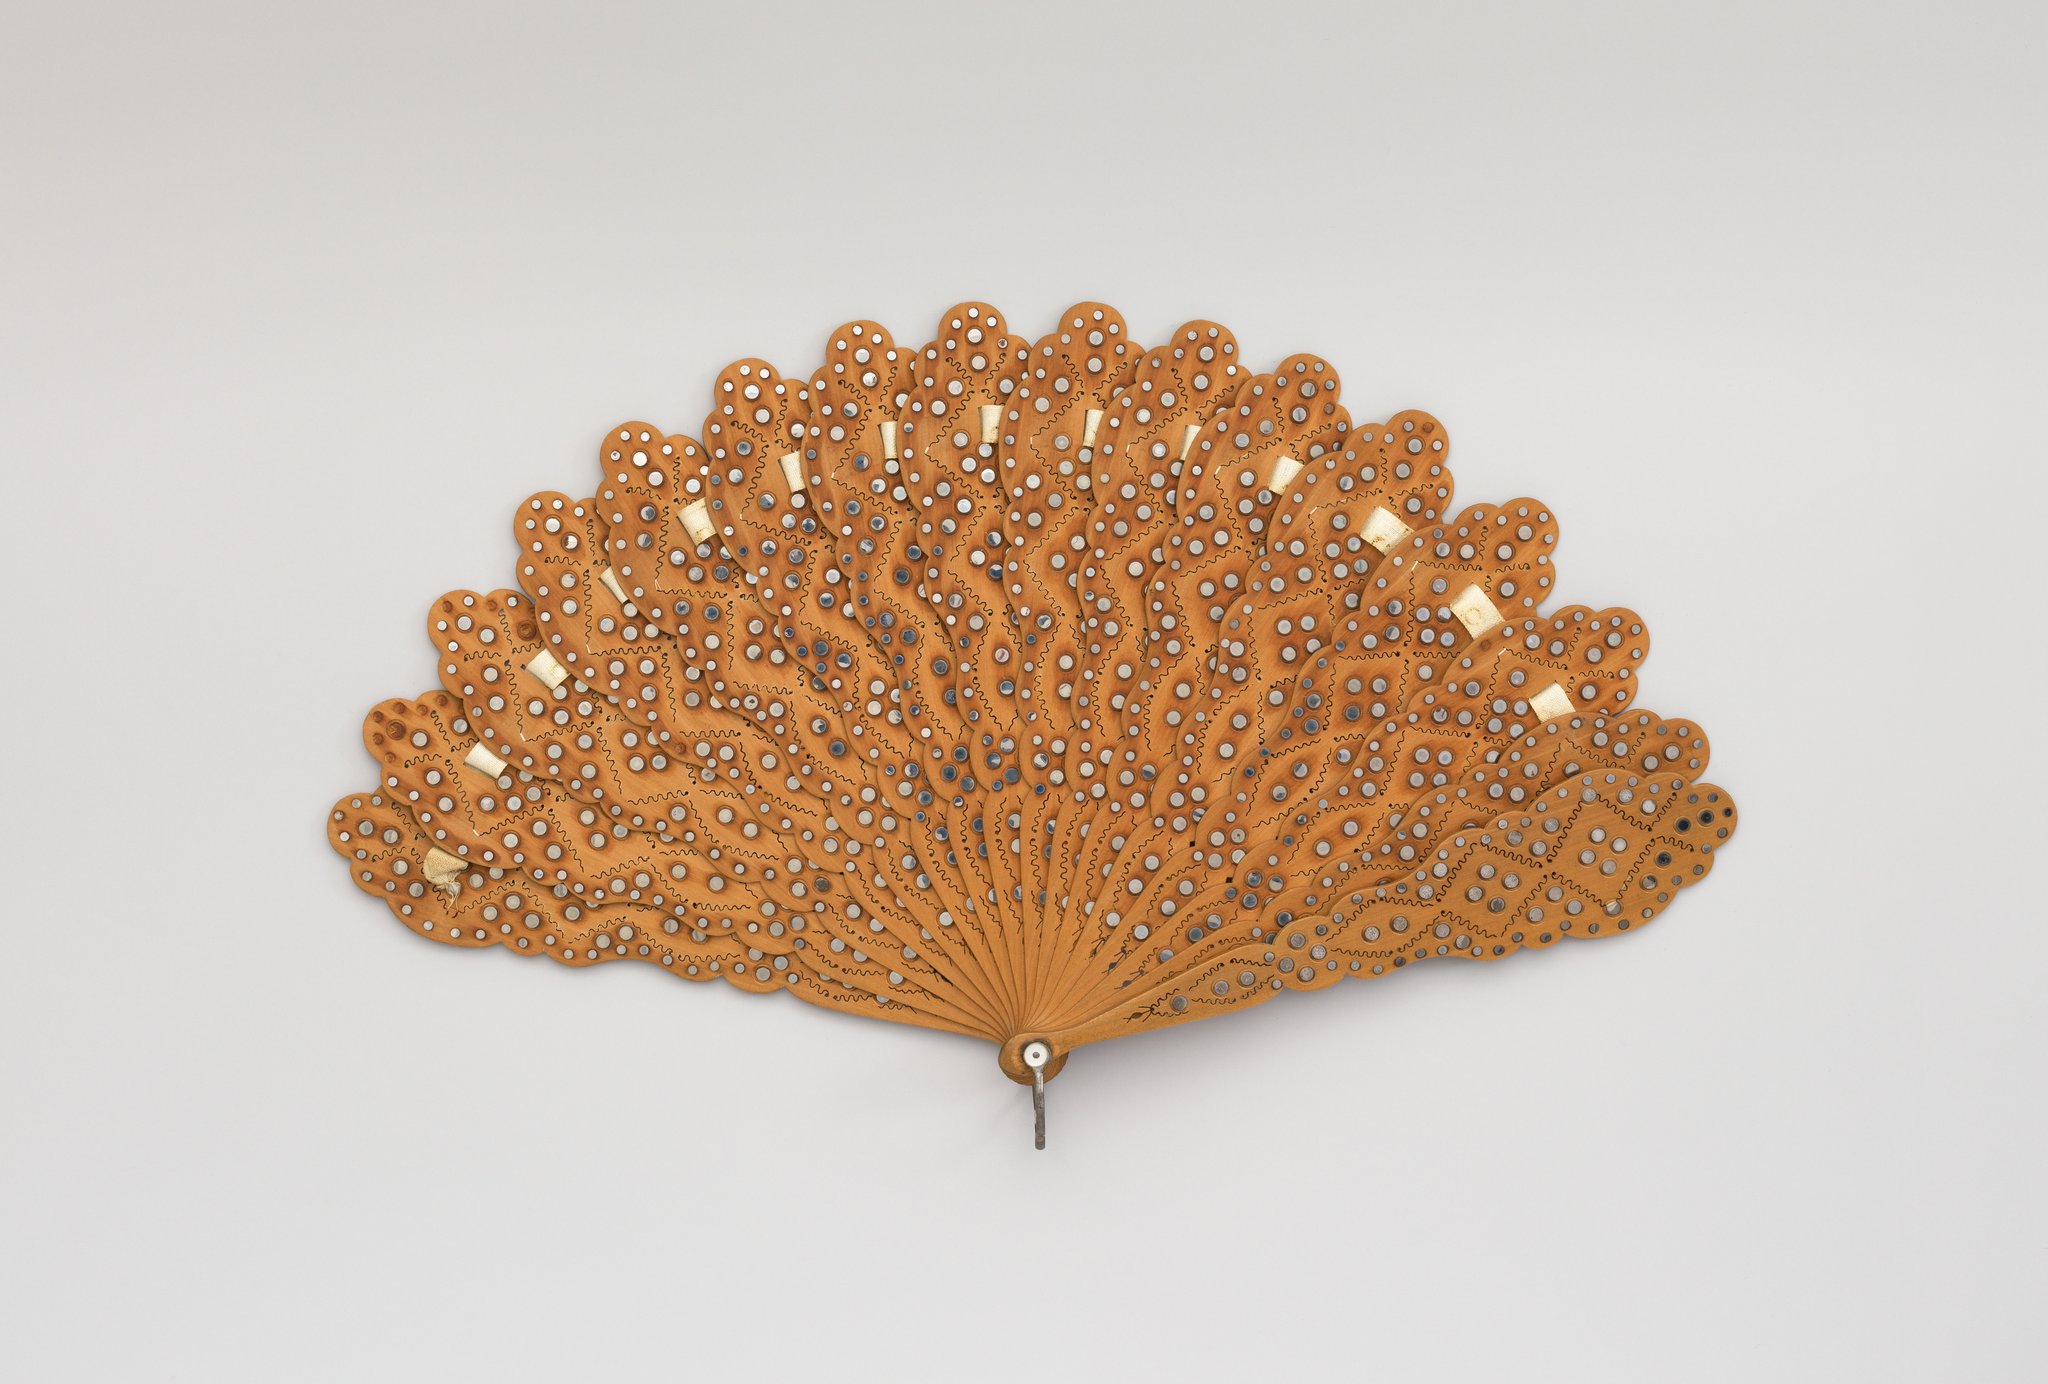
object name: fan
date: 1834-1866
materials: ribbon, textile